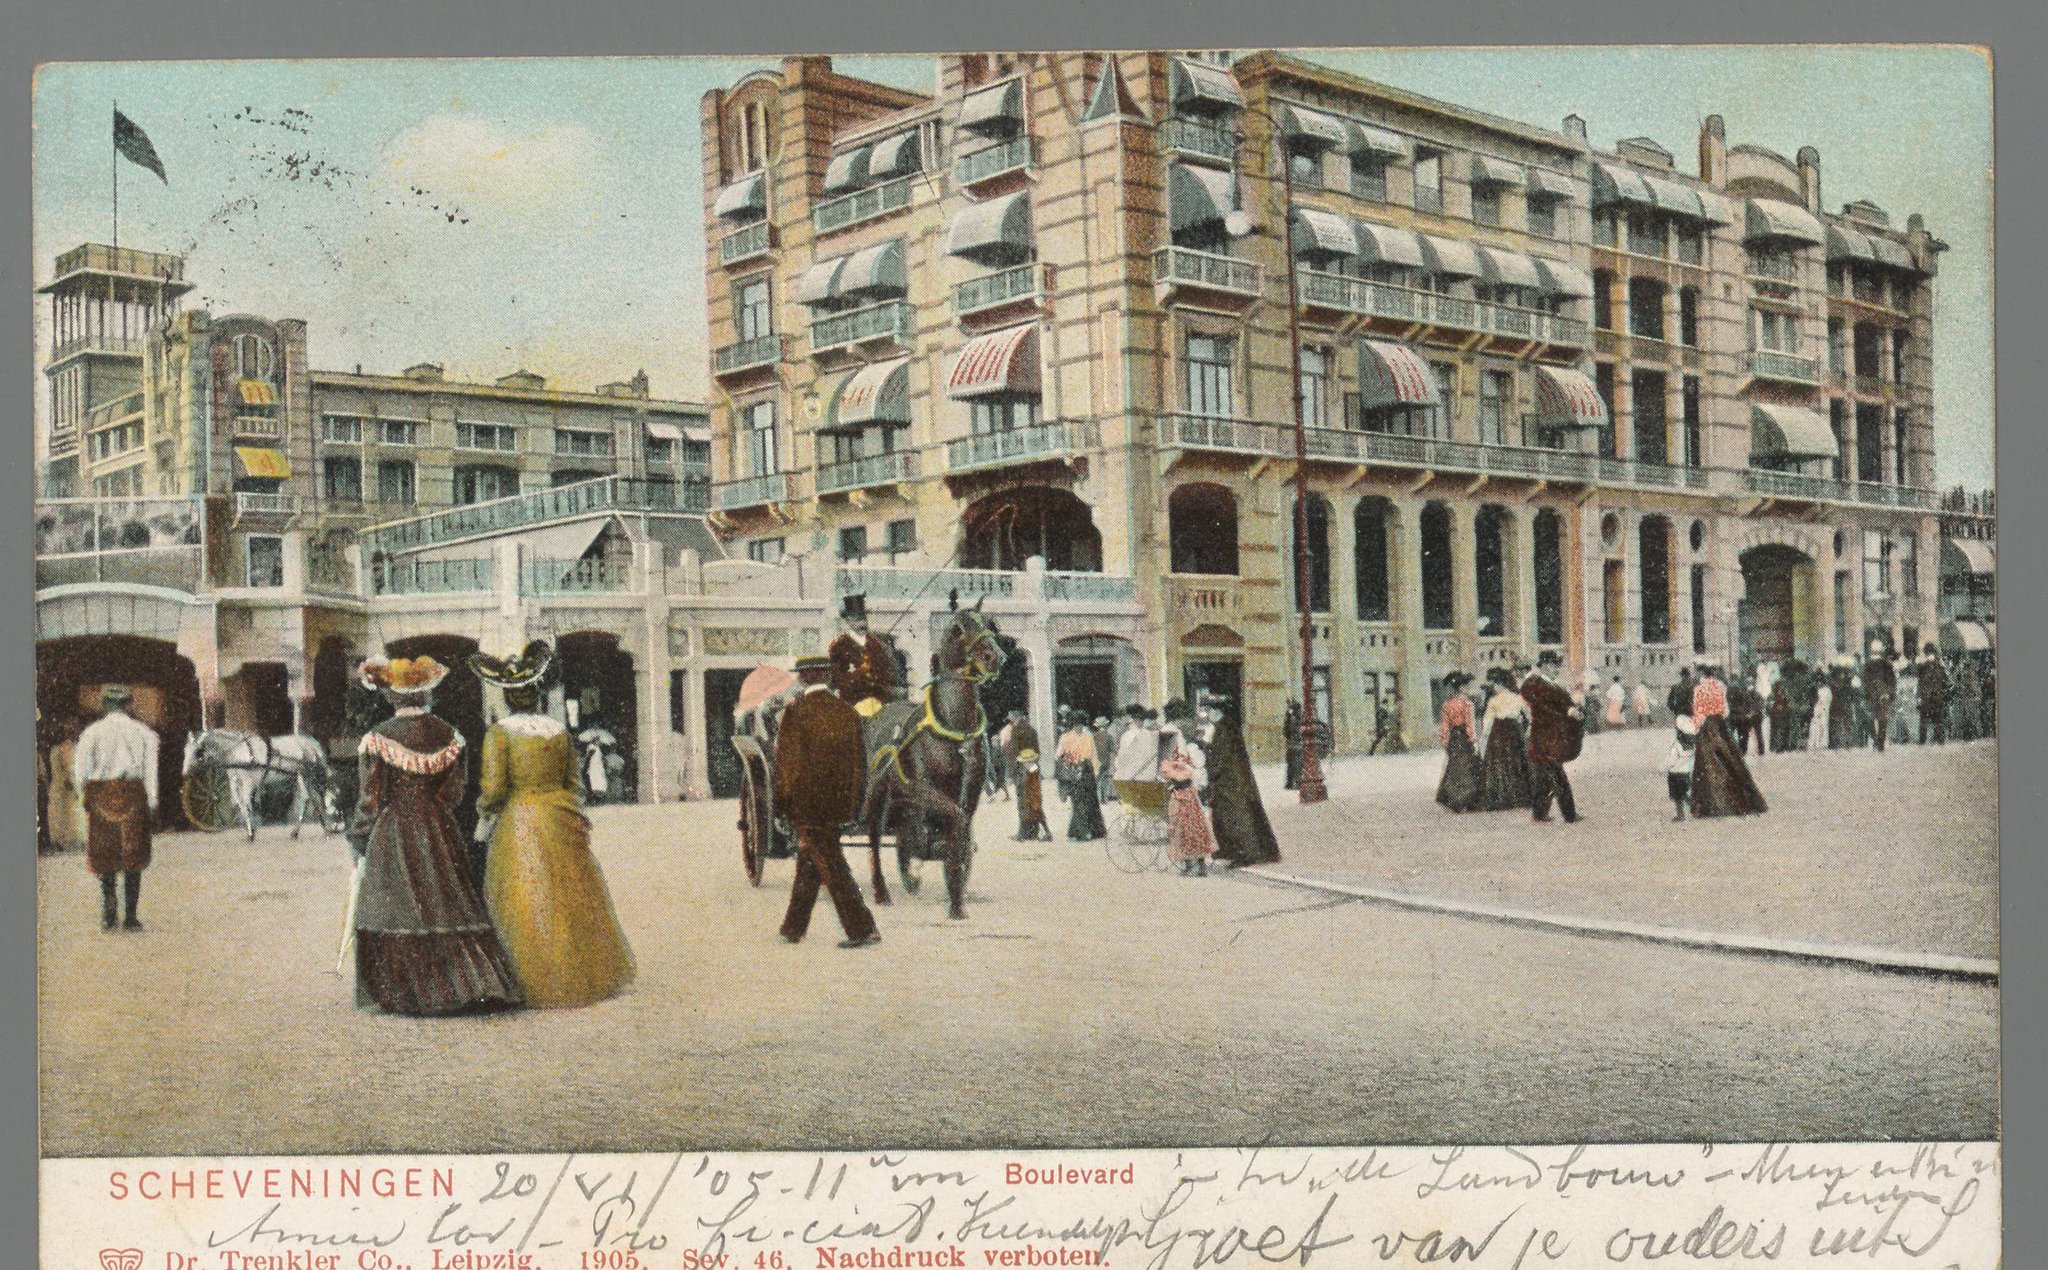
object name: photomechanical print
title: Scheveningen. Boulevard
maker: Anonymous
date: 1905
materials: cardboard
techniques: lithograph, writing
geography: leipzig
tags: avenue, boulevard, promenade, esplanade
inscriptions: postage stamp